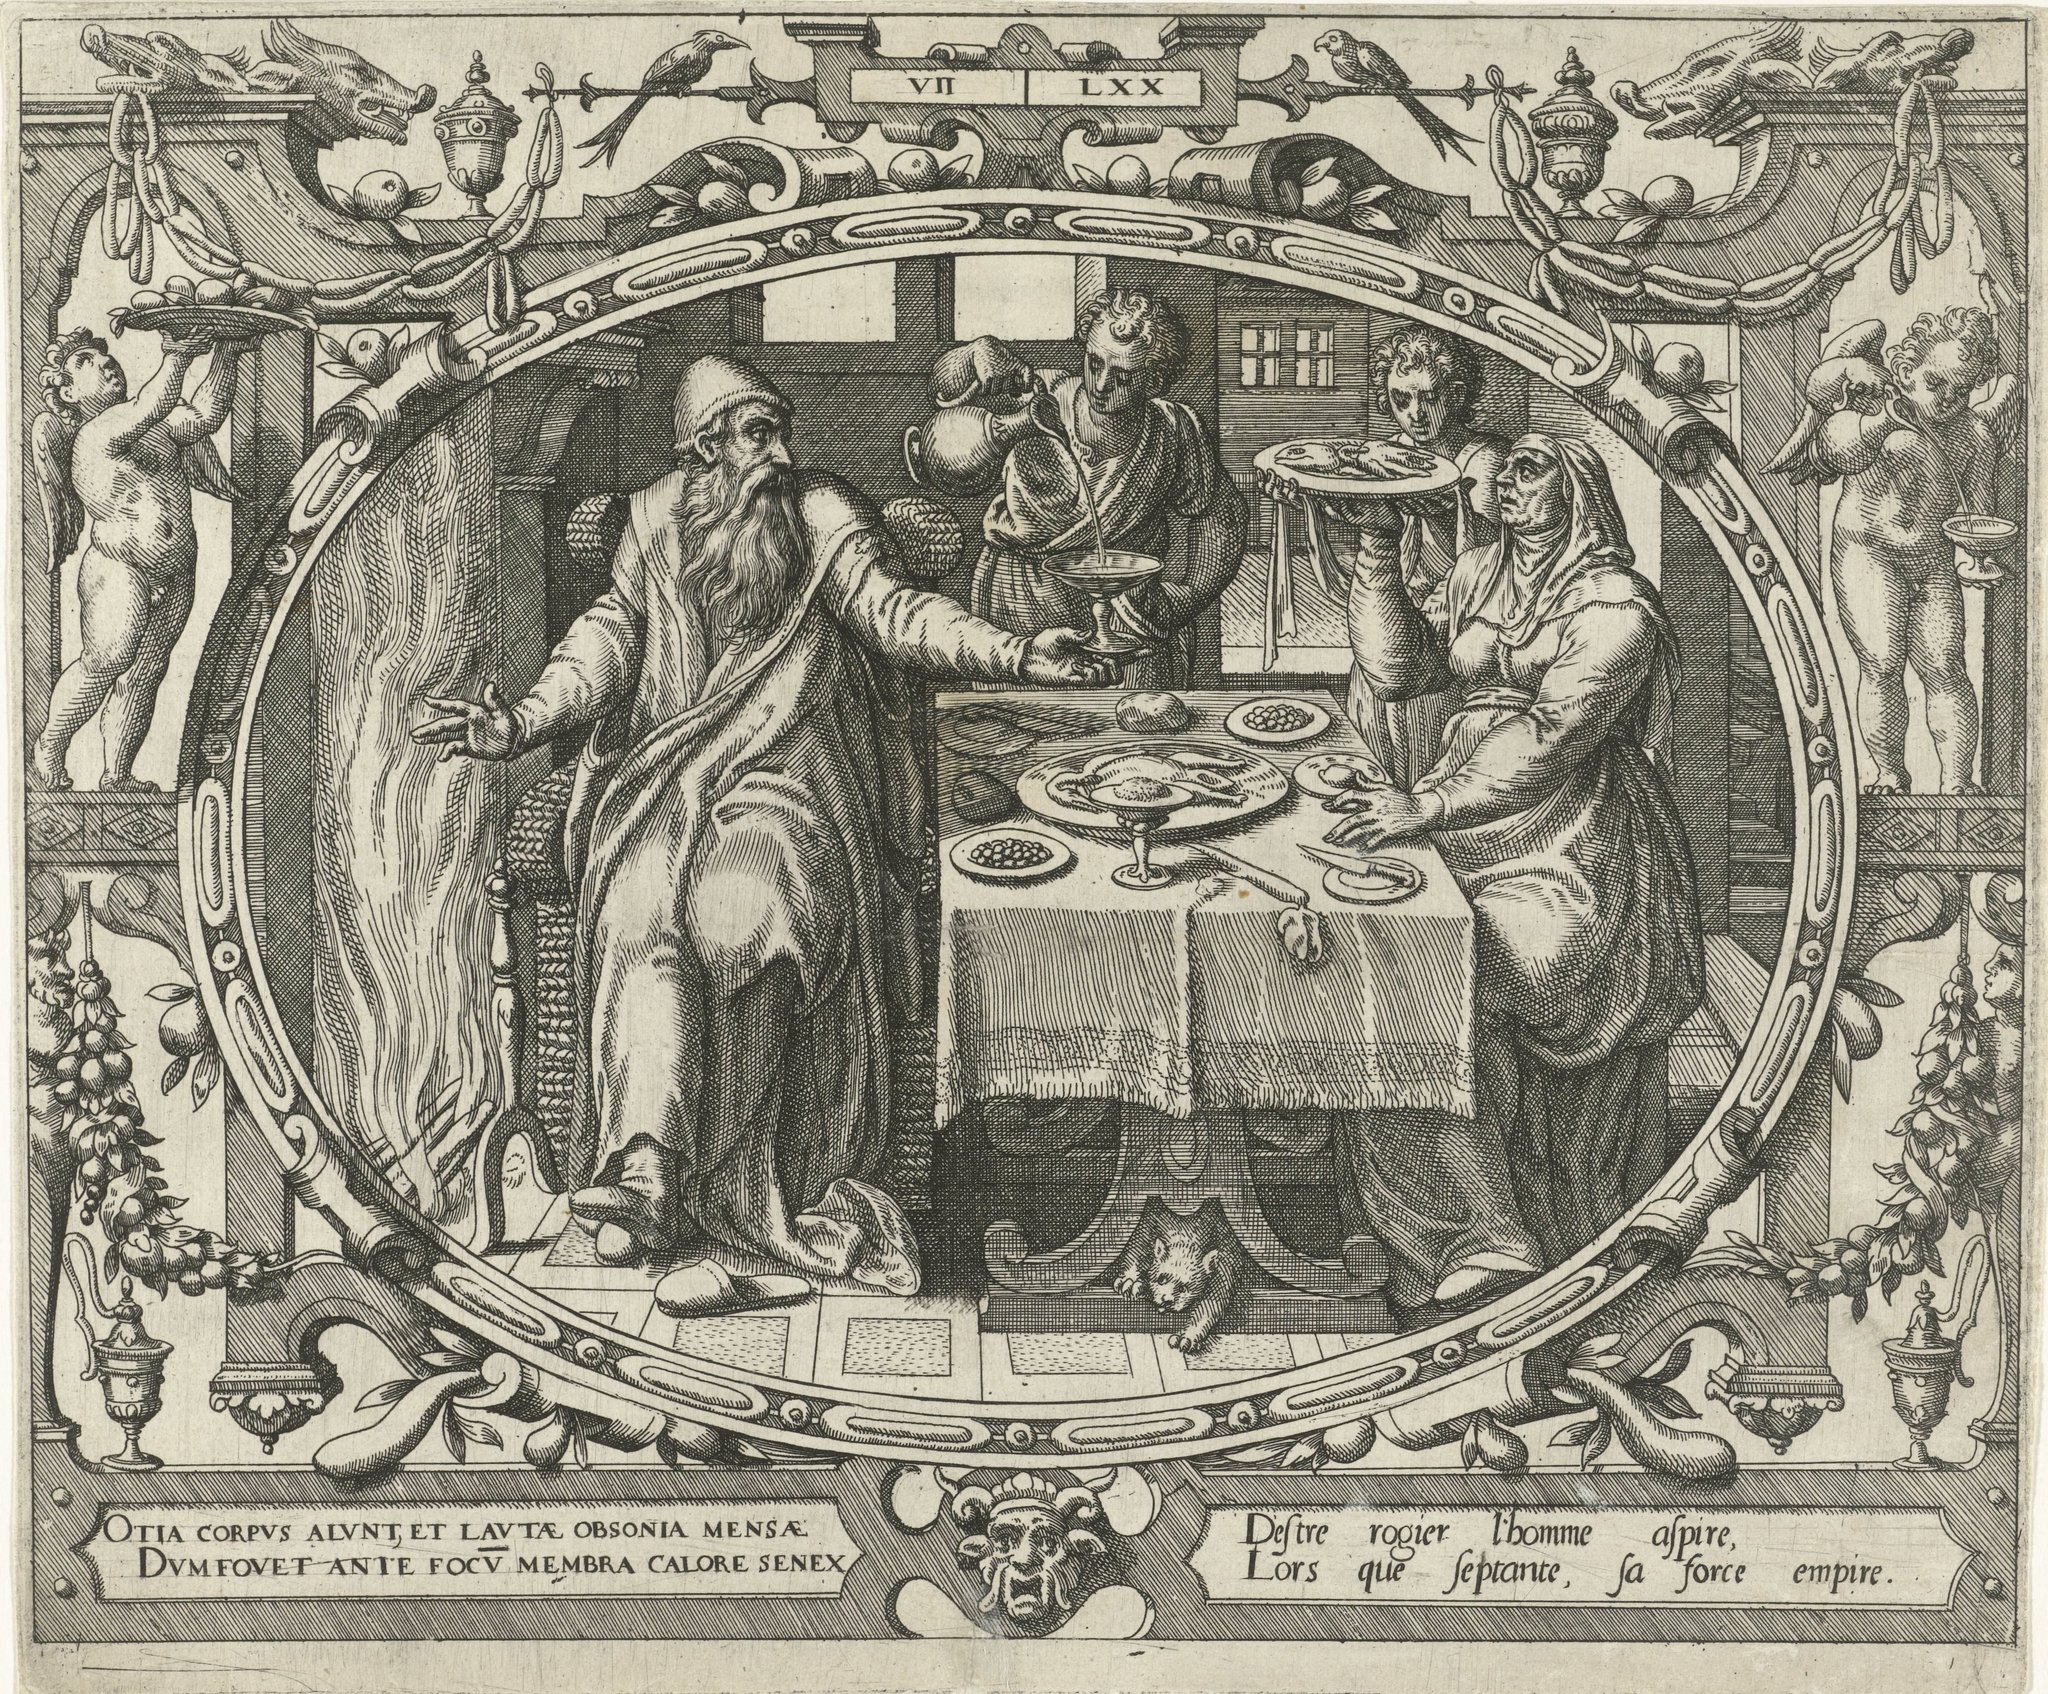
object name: print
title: De mens op zeventigjarige leeftijd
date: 1569-1575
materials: paper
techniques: engraving, etching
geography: antwerp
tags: old man, old woman, celebration meal, feast, banquet, hearth and stove, house personnel, servants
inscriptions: collector's mark: Lugt 2228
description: In een ovaal kader versierd met ornamenten een voorstelling van een oude man samen met zijn vrouw aan tafel bij het haardvuur. Bedienden schenken hen voedsel en drank. De prent heeft een Latijns en Frans onderschrift.